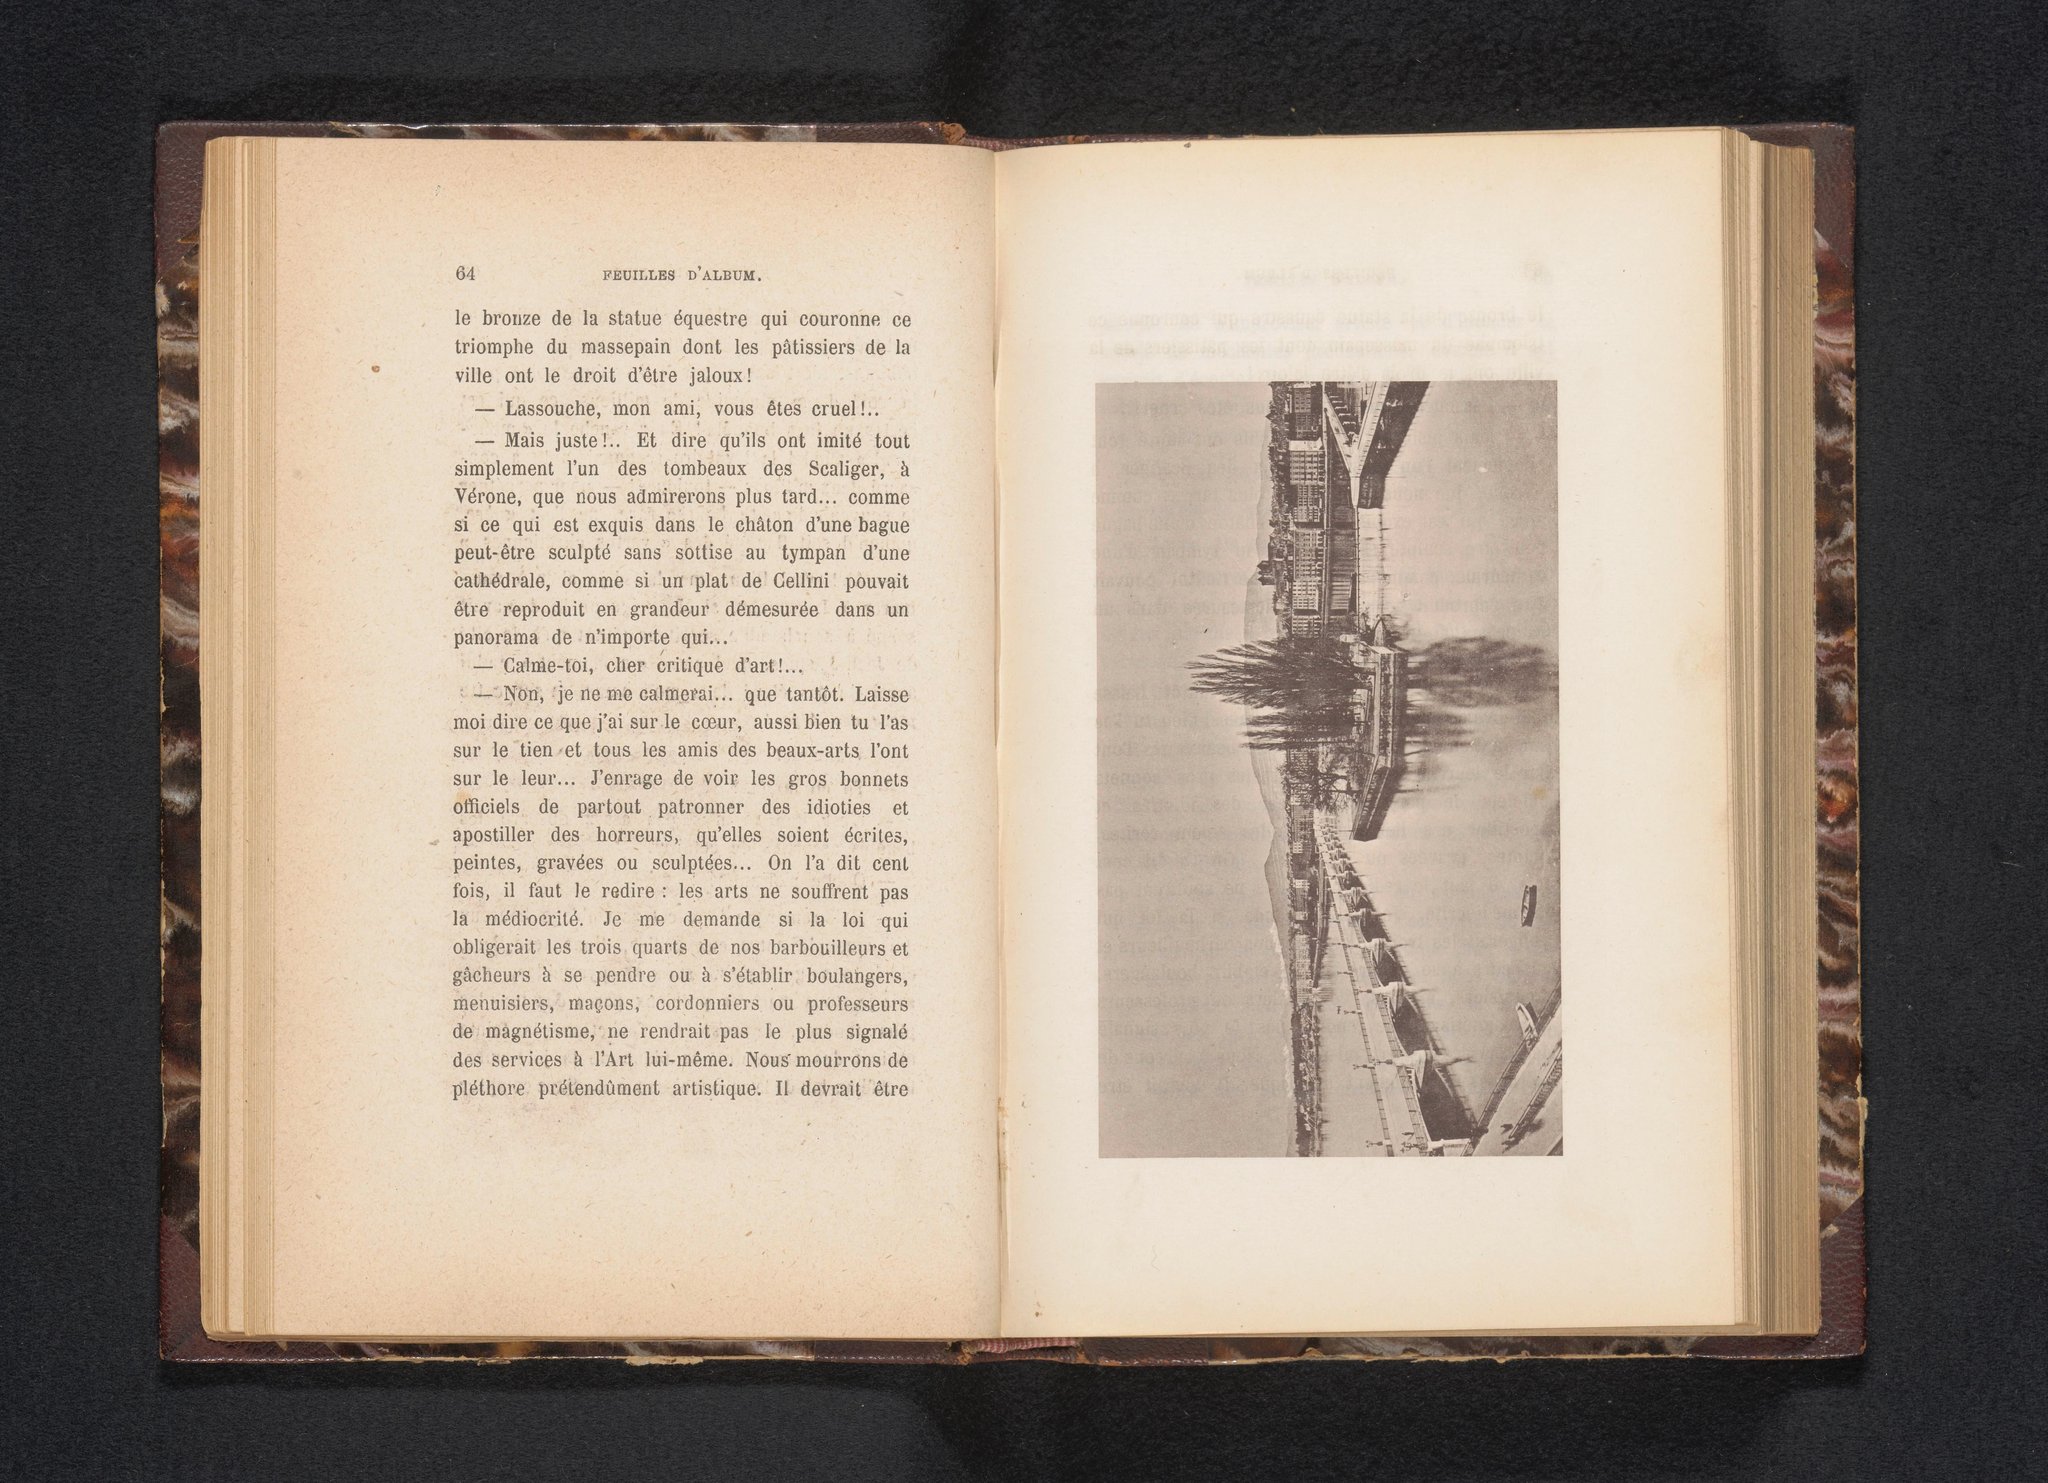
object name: page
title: Gezicht op het eiland van Rousseau in Genève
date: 1884-1889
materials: paper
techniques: photograph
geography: geneva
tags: island, city-view in general; 'veduta'